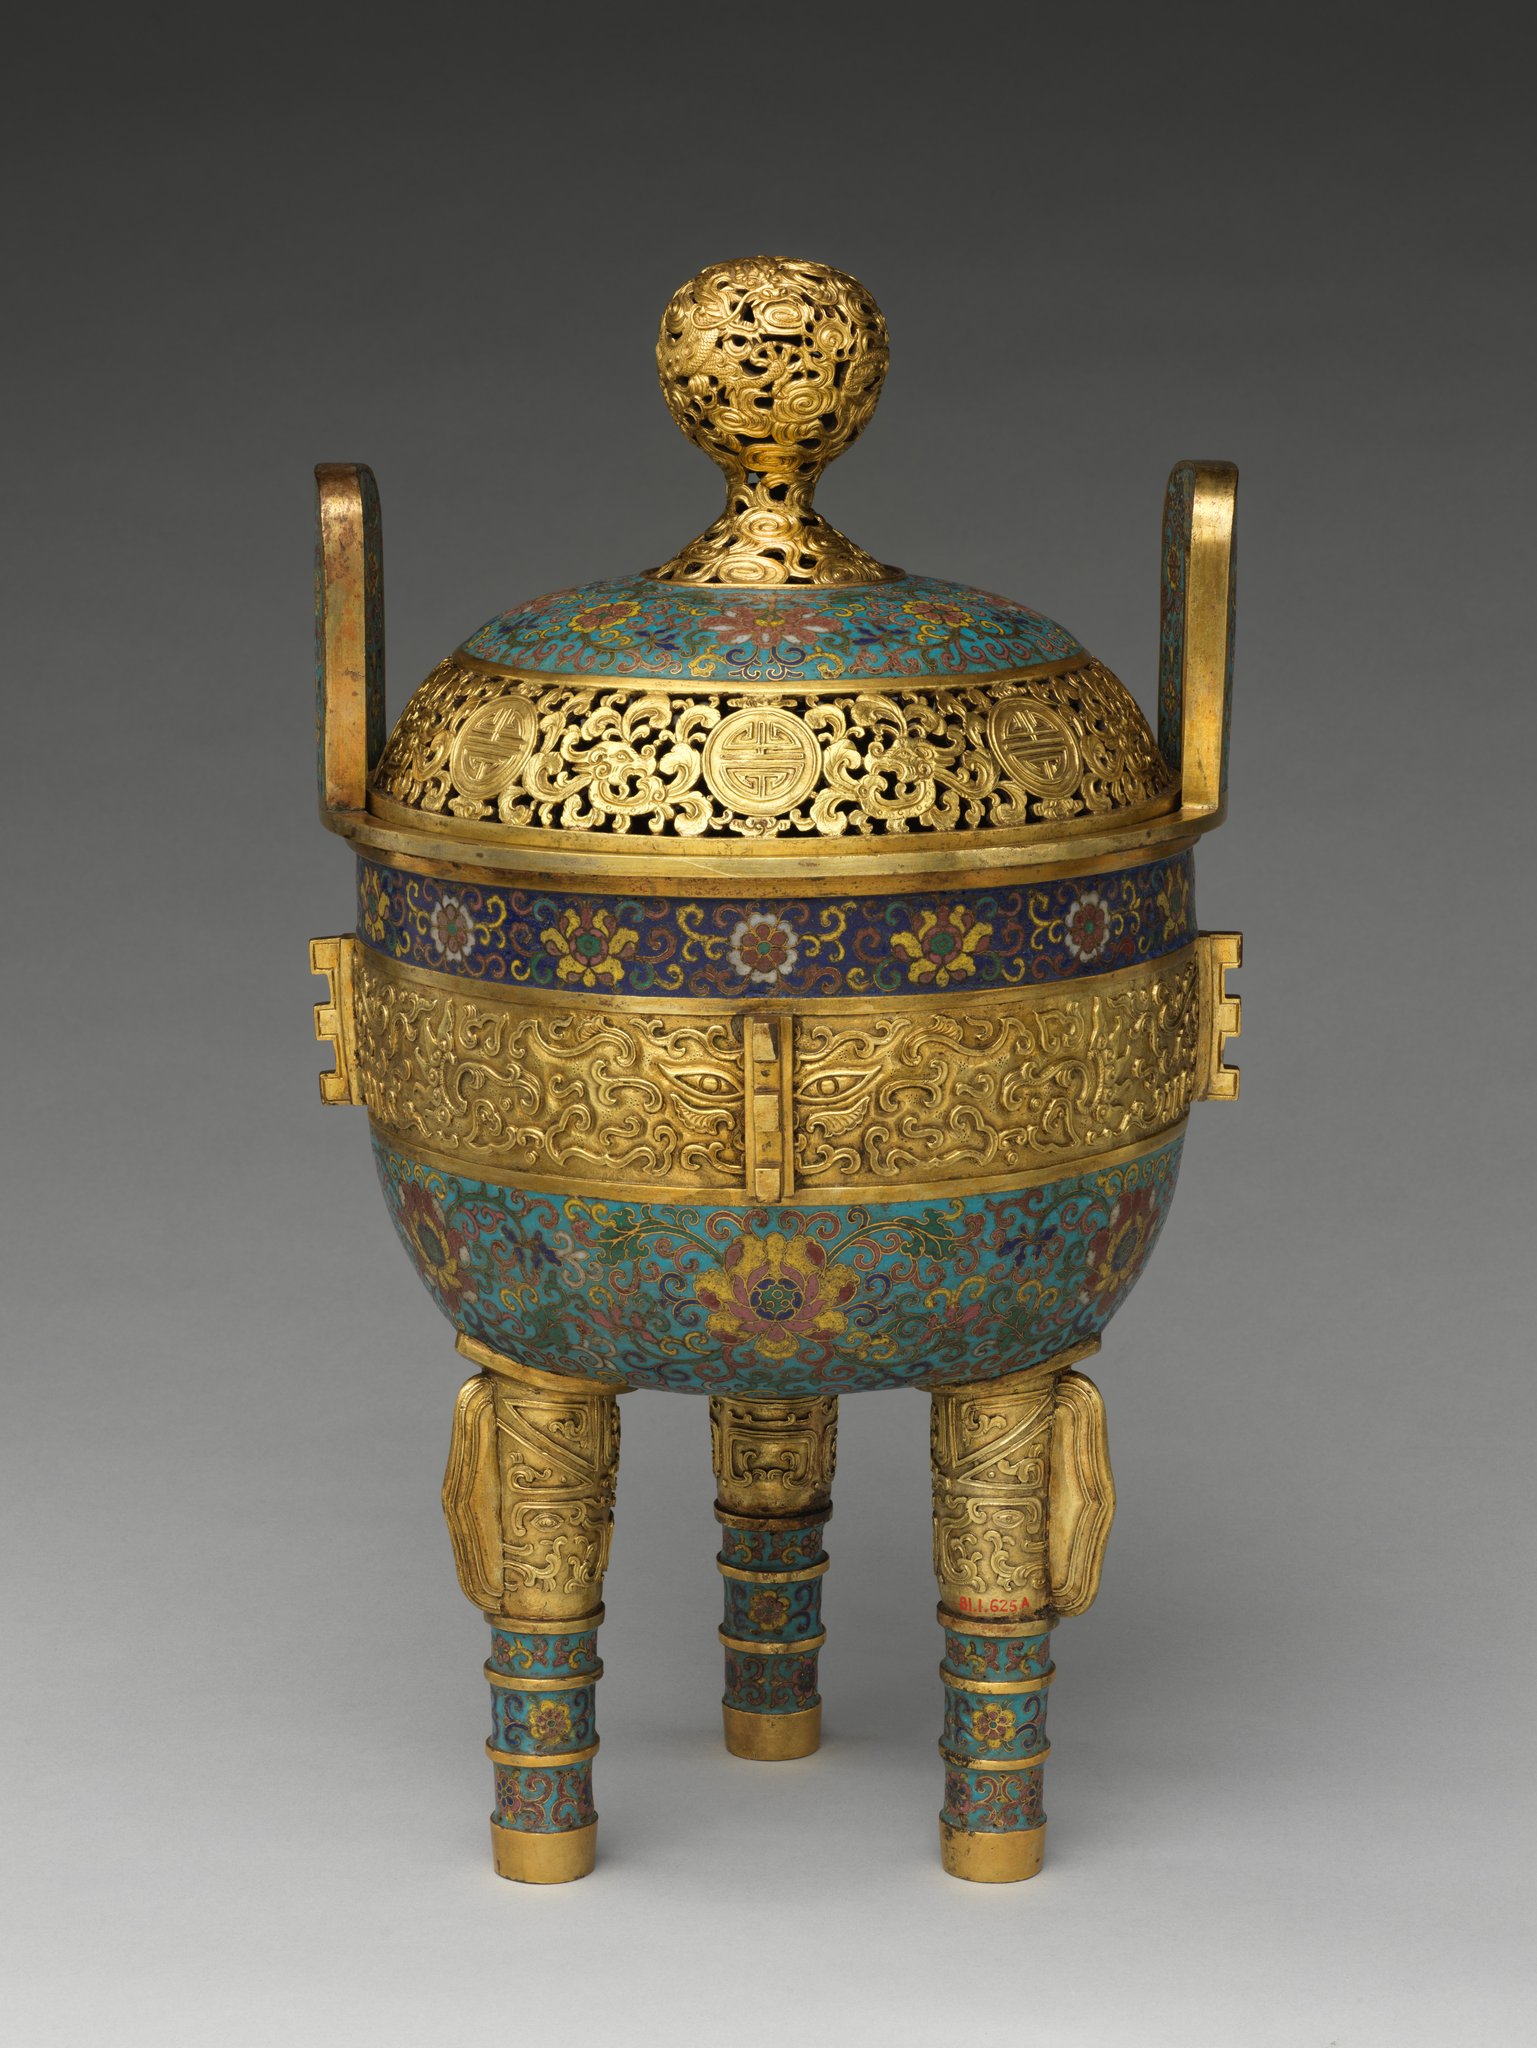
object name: incense burner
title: Tripod incense burner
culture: chinese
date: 1736-1795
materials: enamel, gilt bronze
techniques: enamel